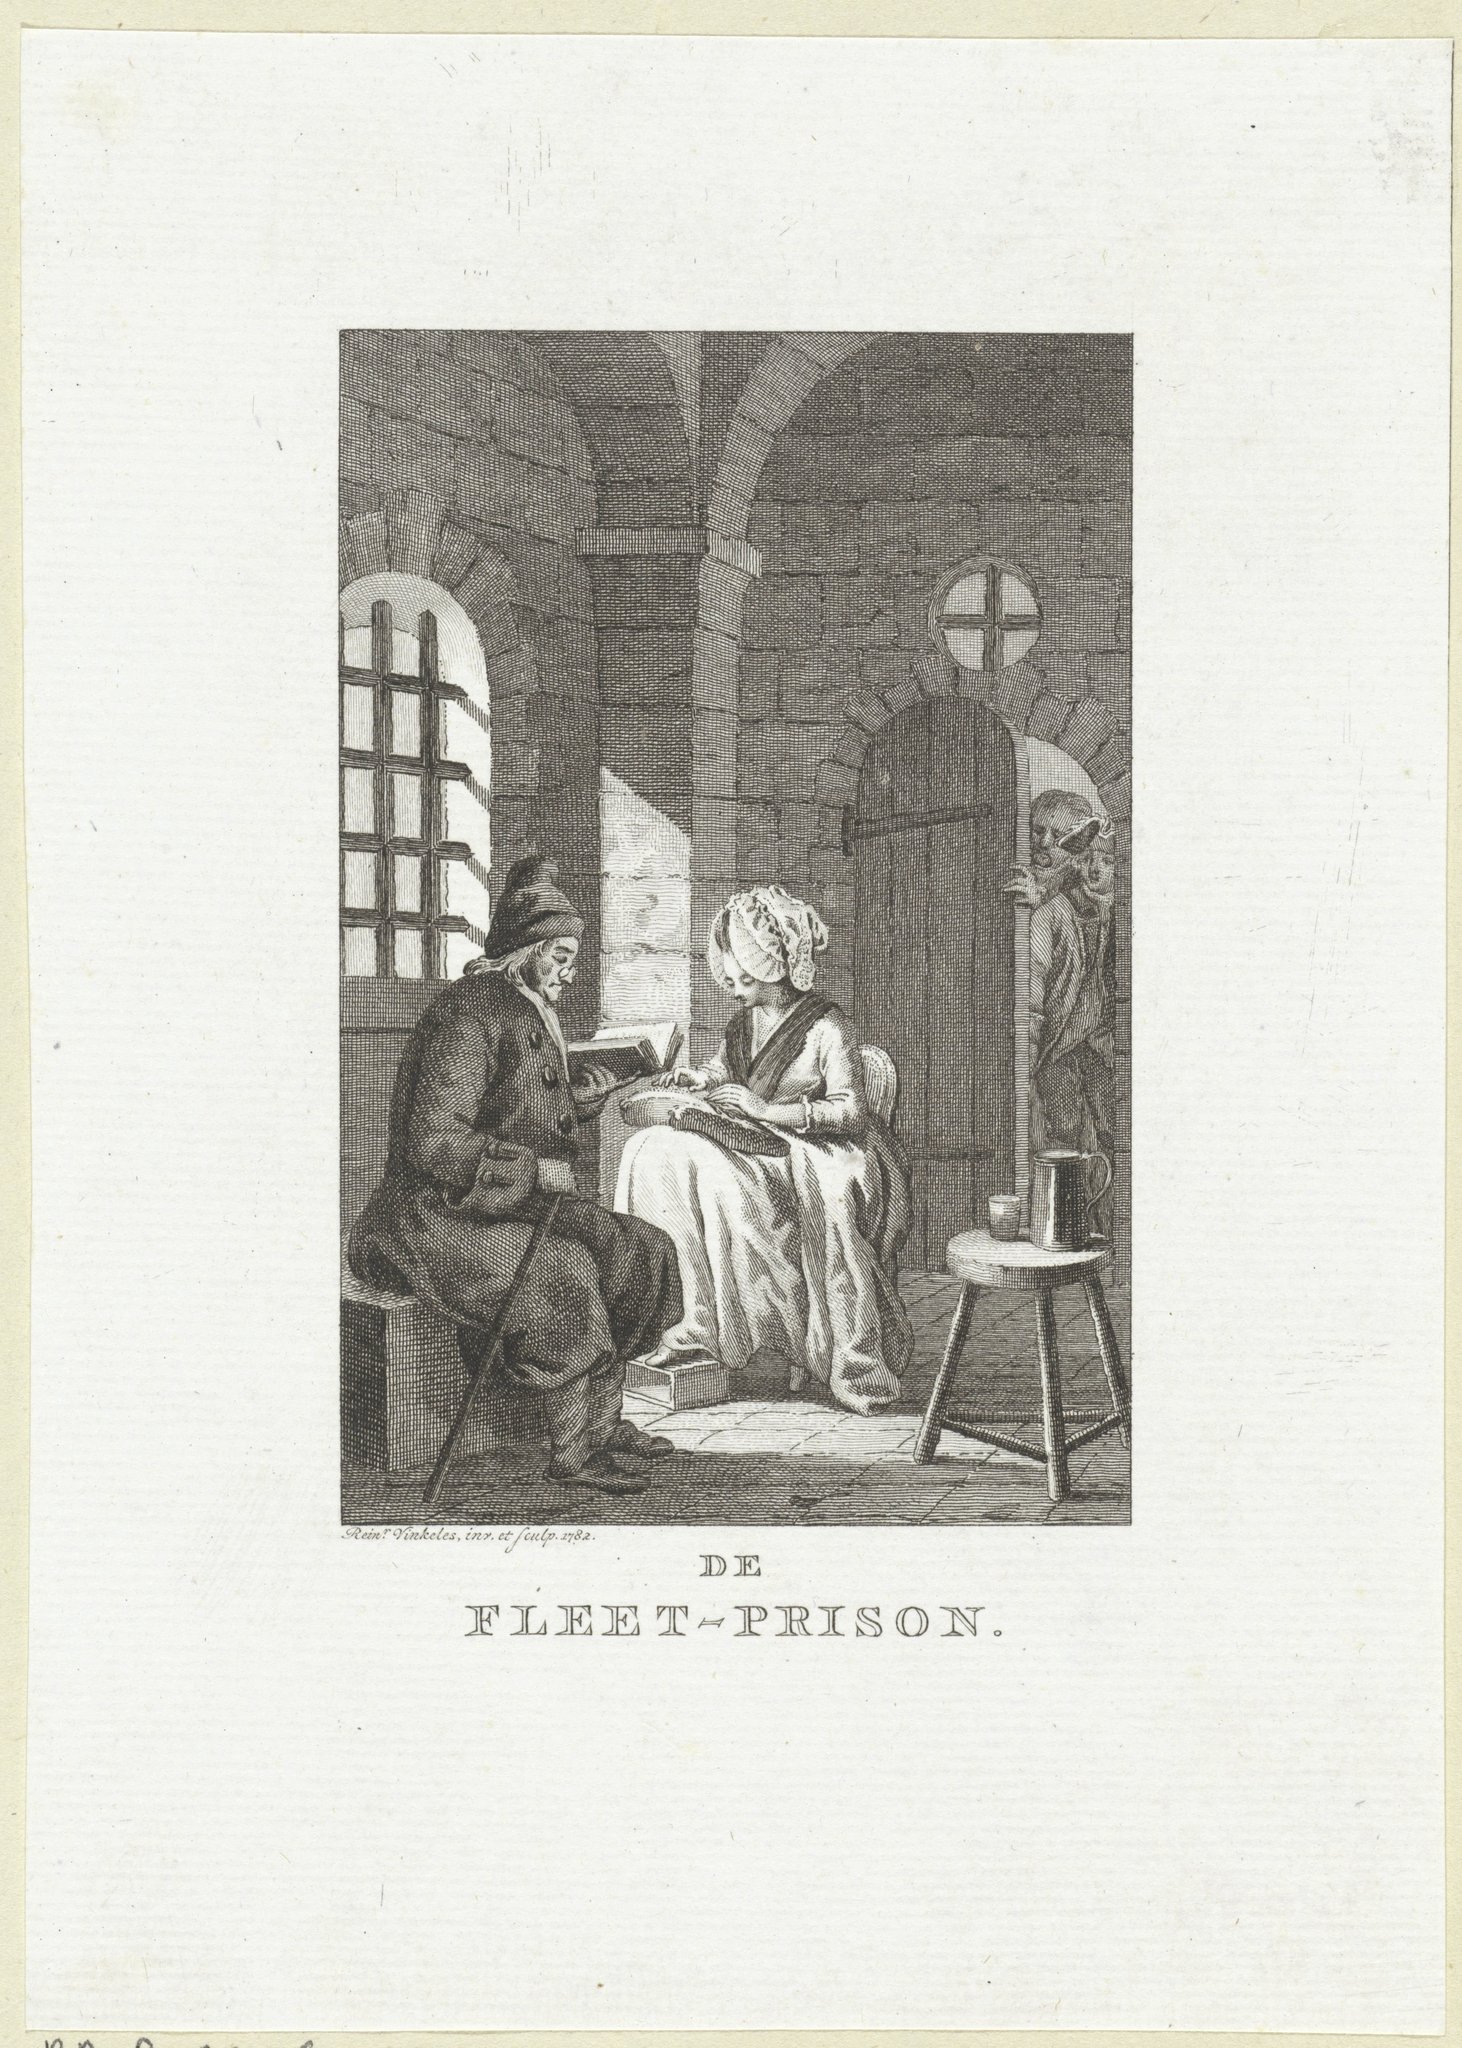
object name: print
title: Oude lezende man en jonge handwerk verrichtende vrouw in een cel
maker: reinier vinkeles (i)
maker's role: draughtsman, print maker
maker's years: 1741-1816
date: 1782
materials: paper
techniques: engraving, etching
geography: amsterdam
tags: prison, jail, reading, needle ~ sewing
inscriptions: collector's mark: Lugt 240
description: Deze prent is ook gebruikt als illustratie bij het verhaal 'De Fleet-Prison' voor: Brooke, H. Zedelijke verhaalen, deel 7. Amsterdam: A. Mens Jansz., 1782.